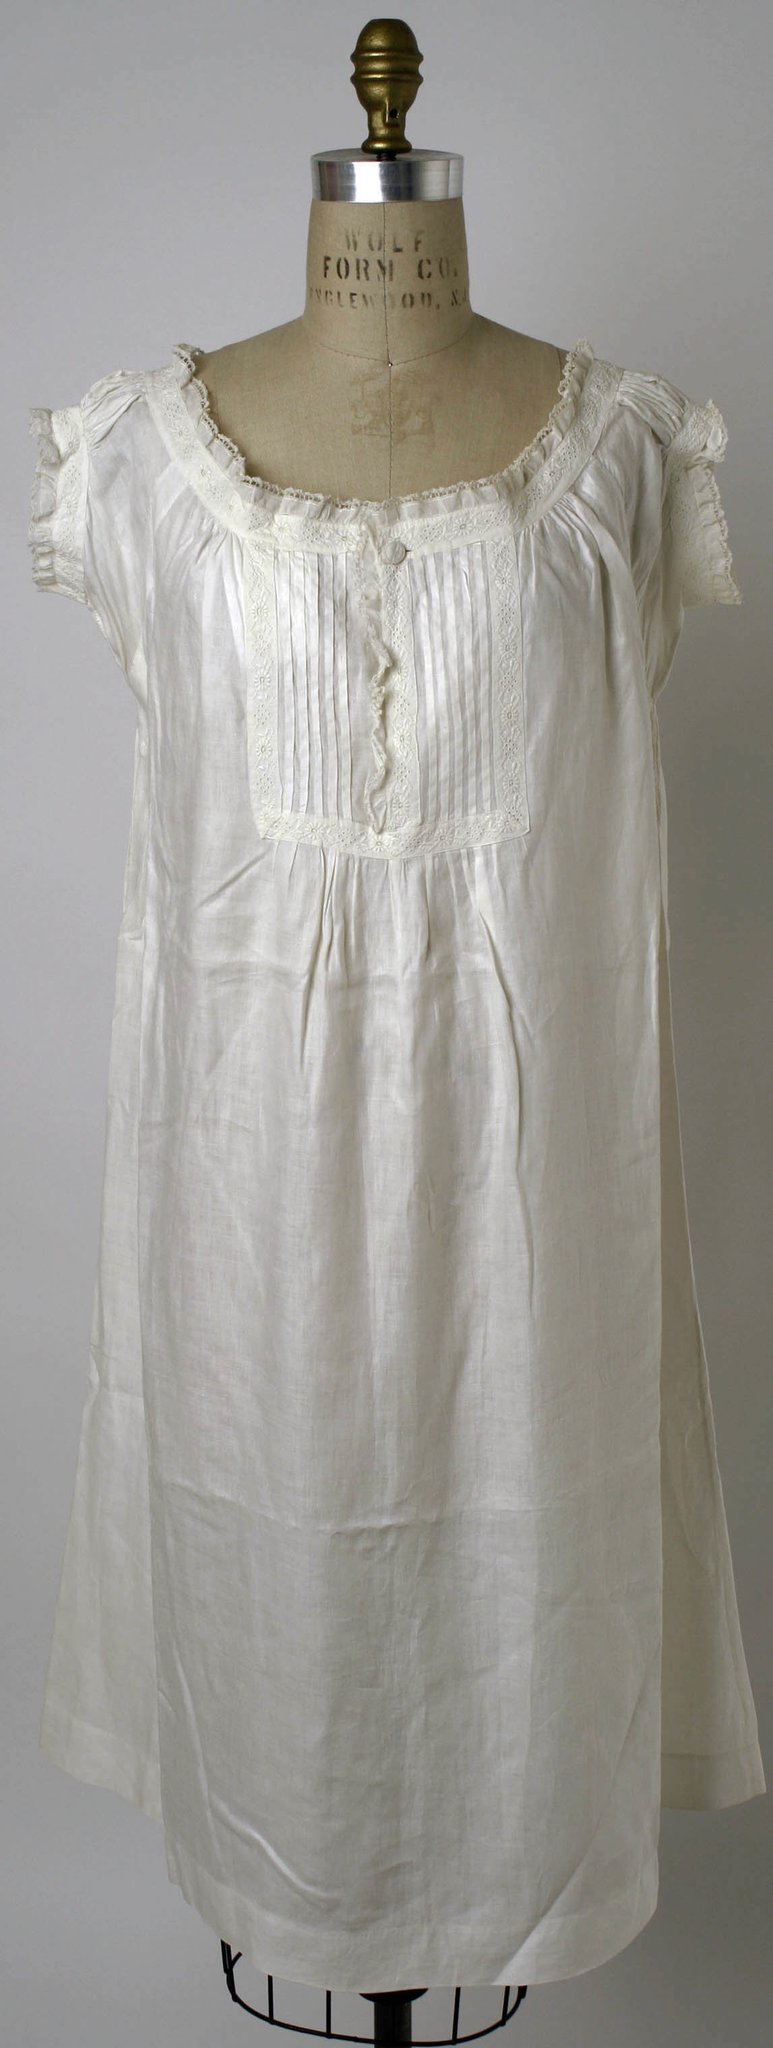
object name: chemise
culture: american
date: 1860-1869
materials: linen